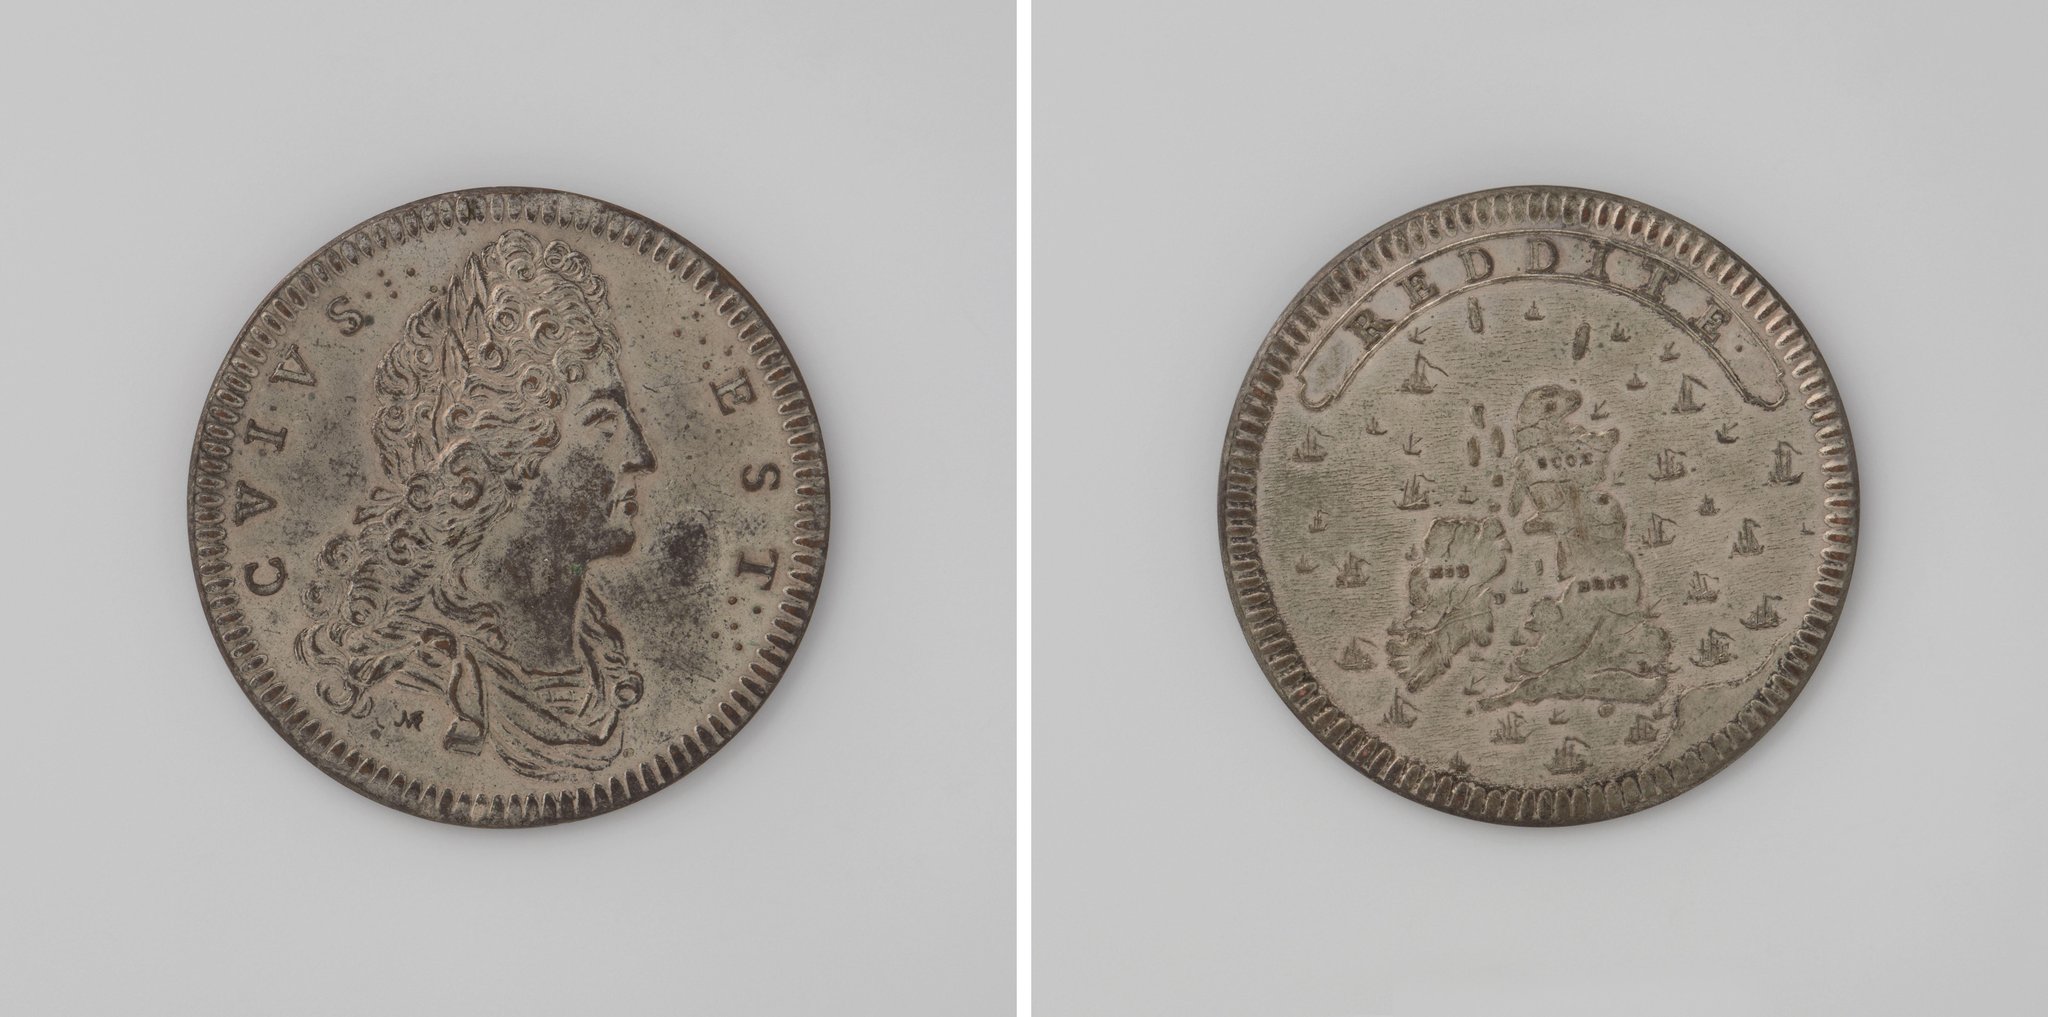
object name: history medal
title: Jacobus III, penning geslagen om onder zijn partijgangers te verdelen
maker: norbert roëttiers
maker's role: medailleur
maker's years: 1666-1727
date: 1708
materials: silver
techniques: striking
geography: paris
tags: jacobus frans eduard stuart (prins van wales)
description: Zilveren penning. Voorzijde: borststuk man binnen omschrift. Keerzijde: kaart van Groot-Brittanie met schepen op zee binnen omschrift